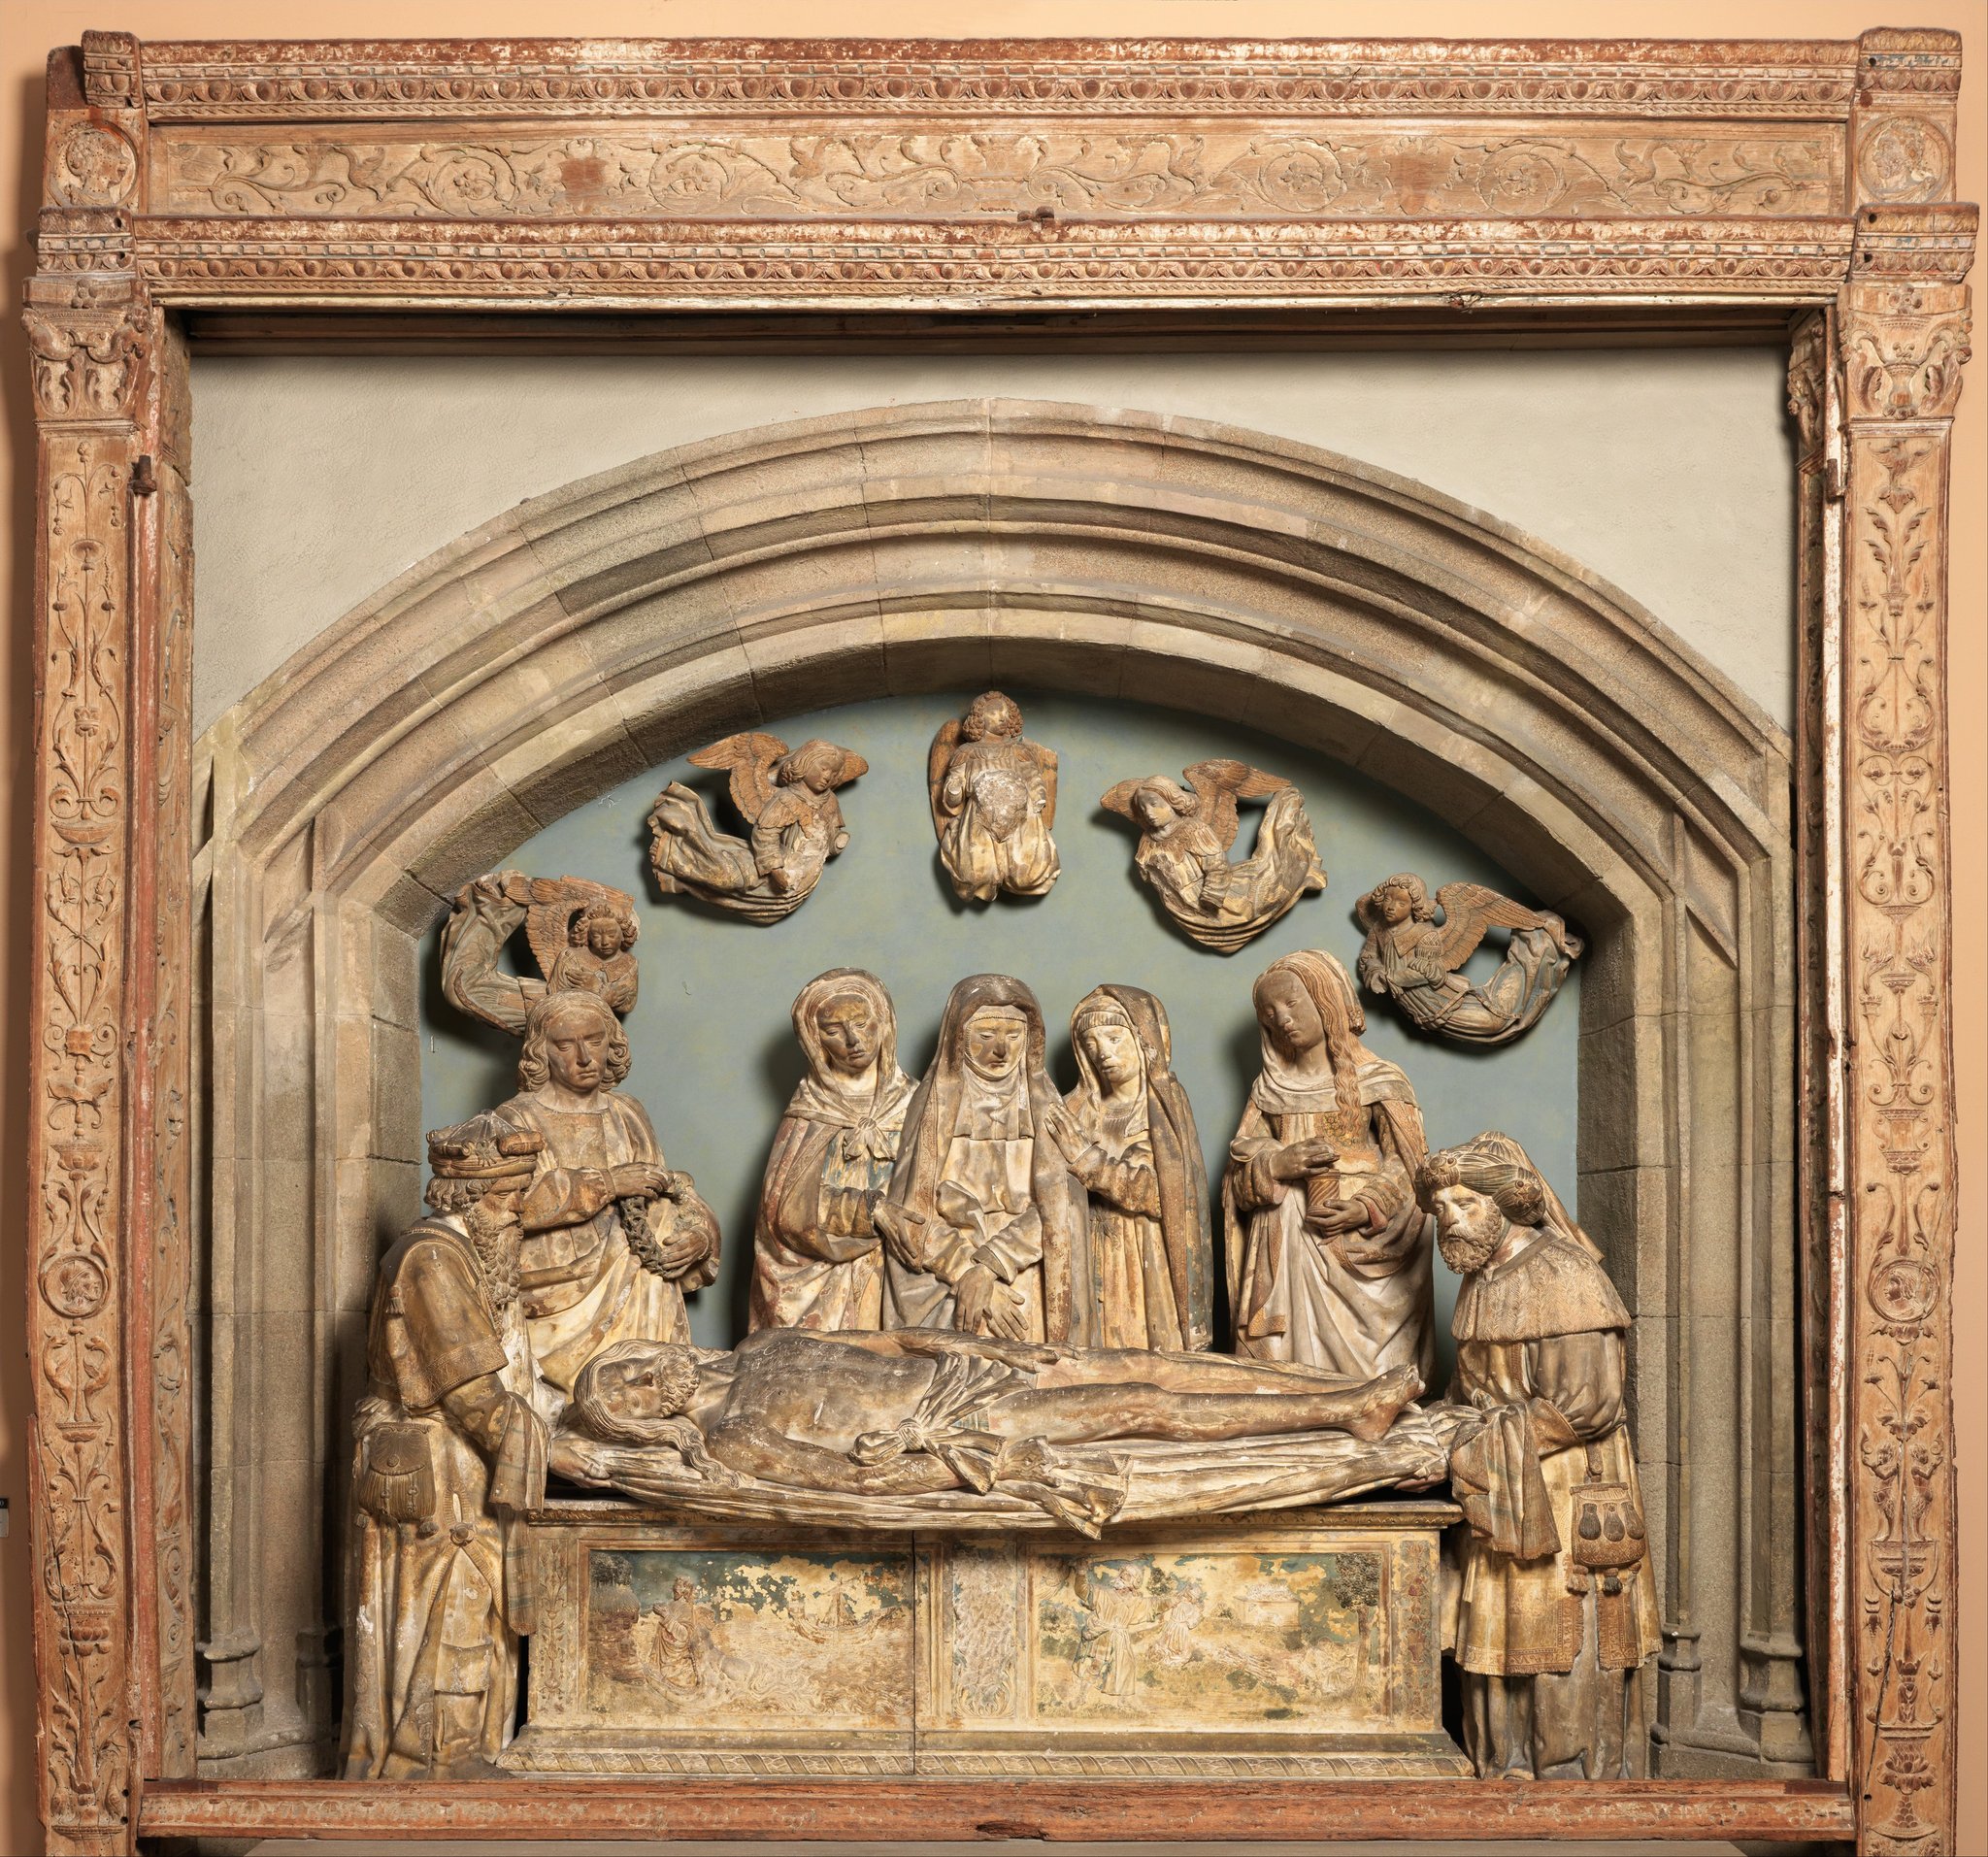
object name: frame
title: Wooden Frame from an Entombment Group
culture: french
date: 1501-1600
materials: wood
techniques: polychromy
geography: france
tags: angels